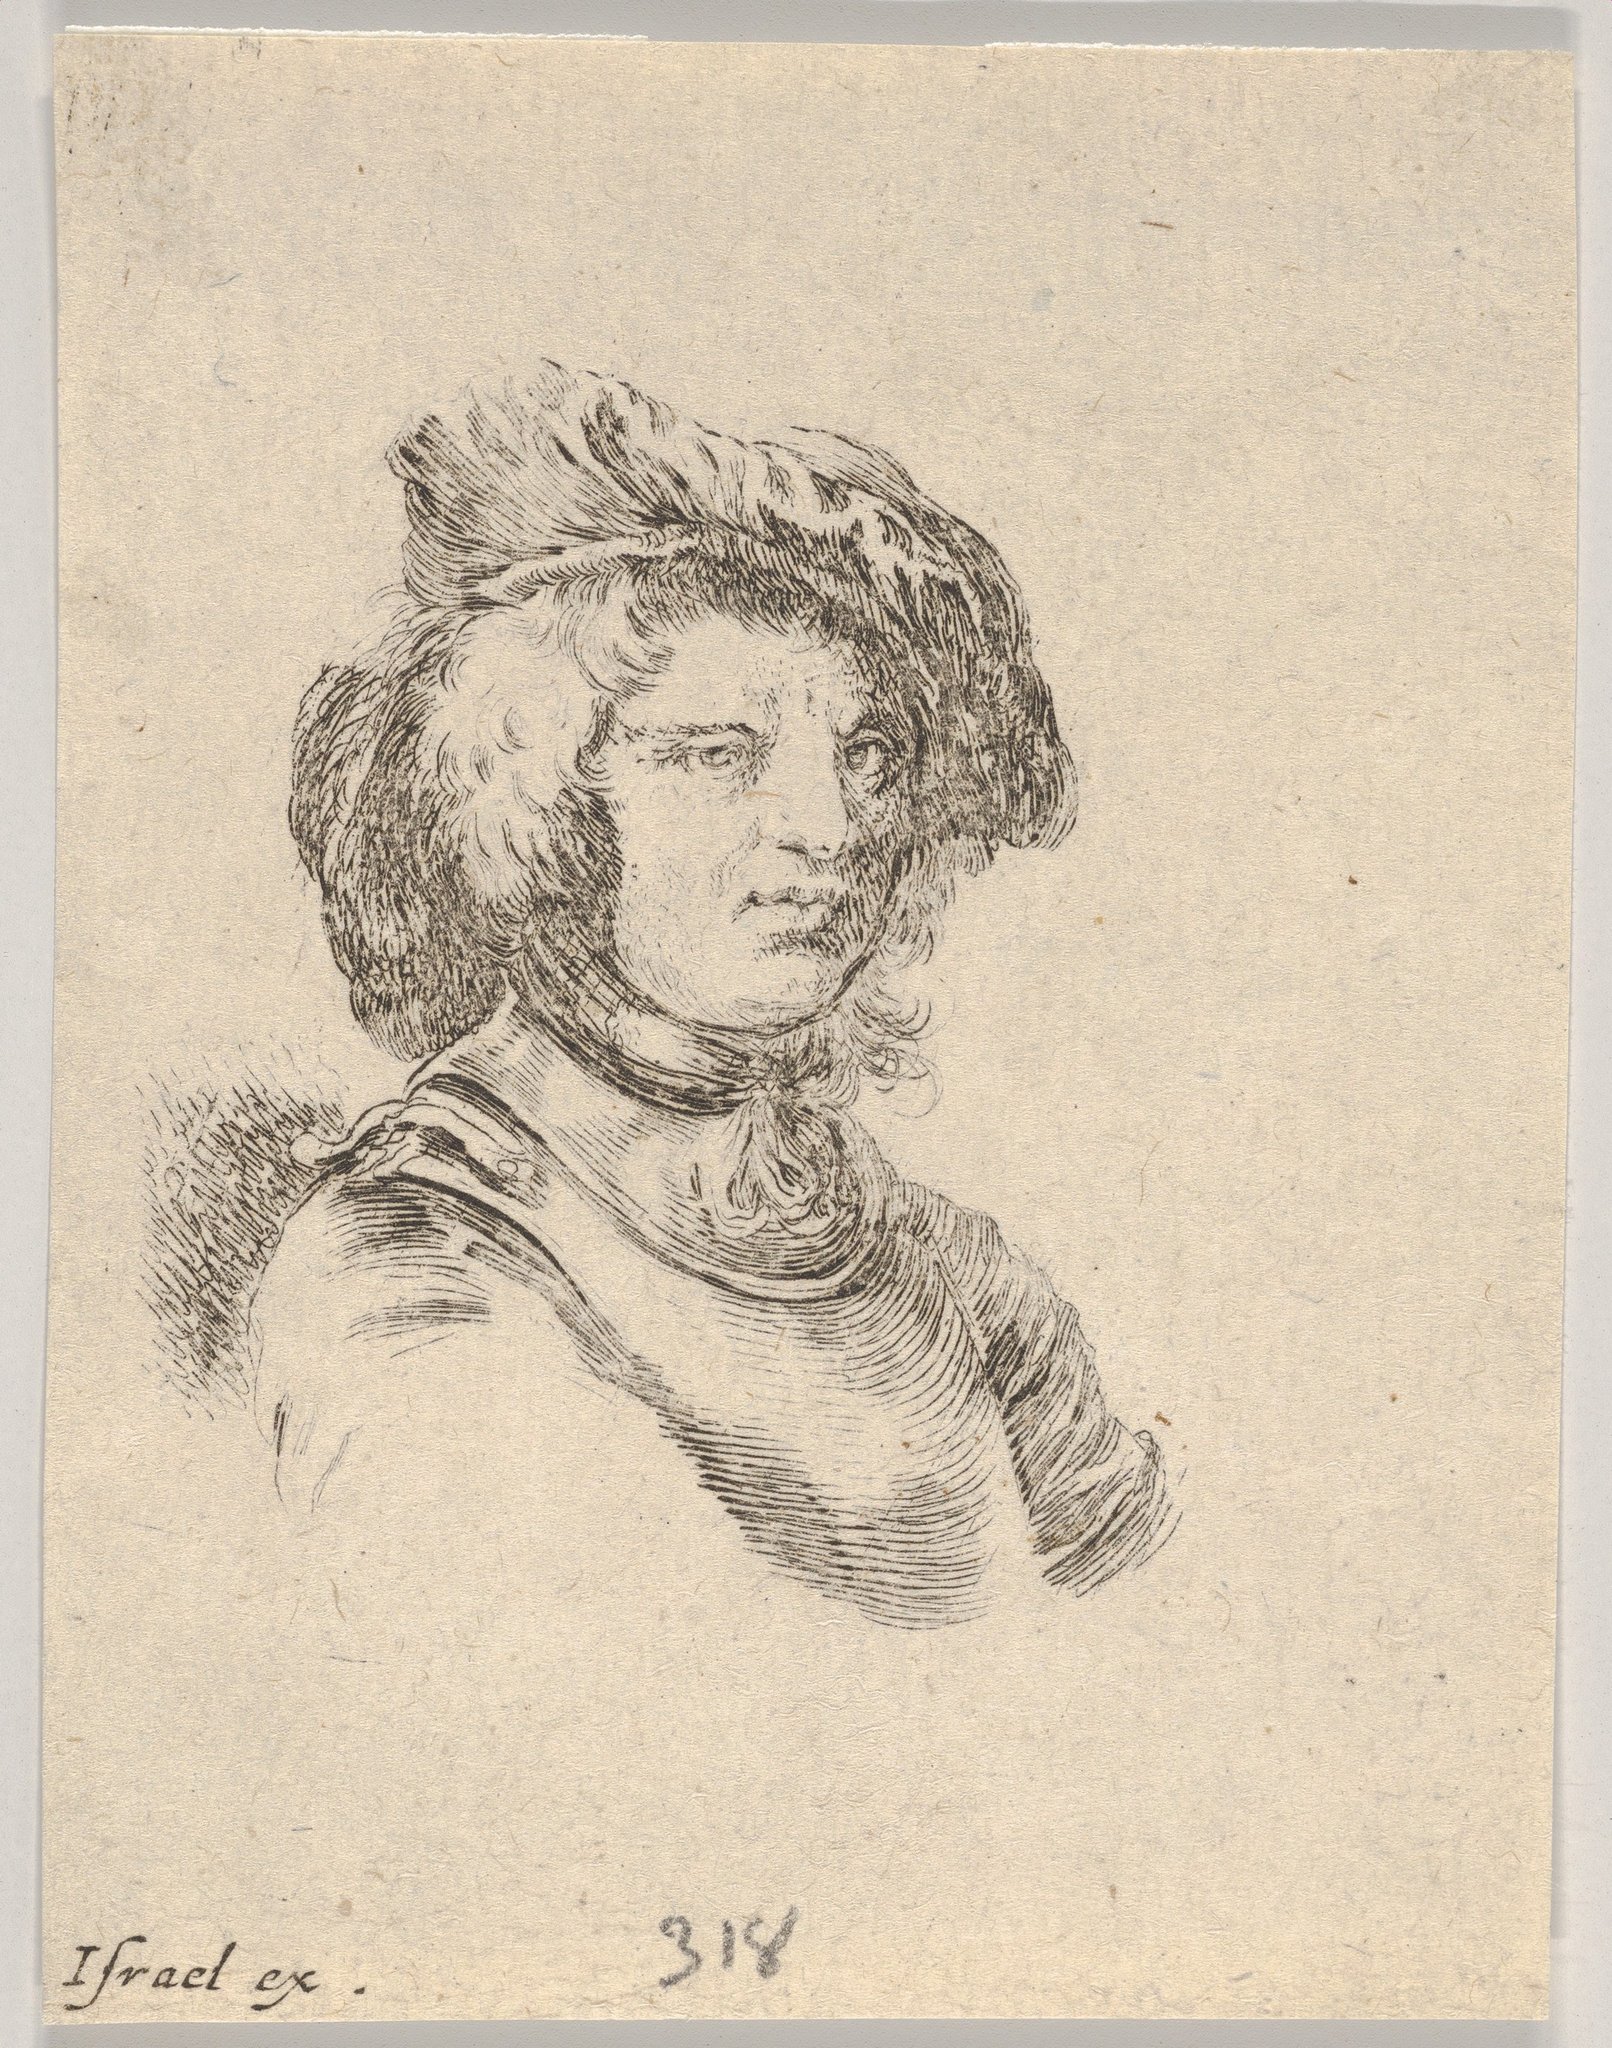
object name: print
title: Plate 11: bust of a man wearing a cap and looking towards the right, from "Various heads and figures" (Diverses têtes et figures)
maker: stefano della bella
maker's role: artist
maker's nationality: italian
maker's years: 1610-1664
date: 1650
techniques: etching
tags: hats,men,portraits